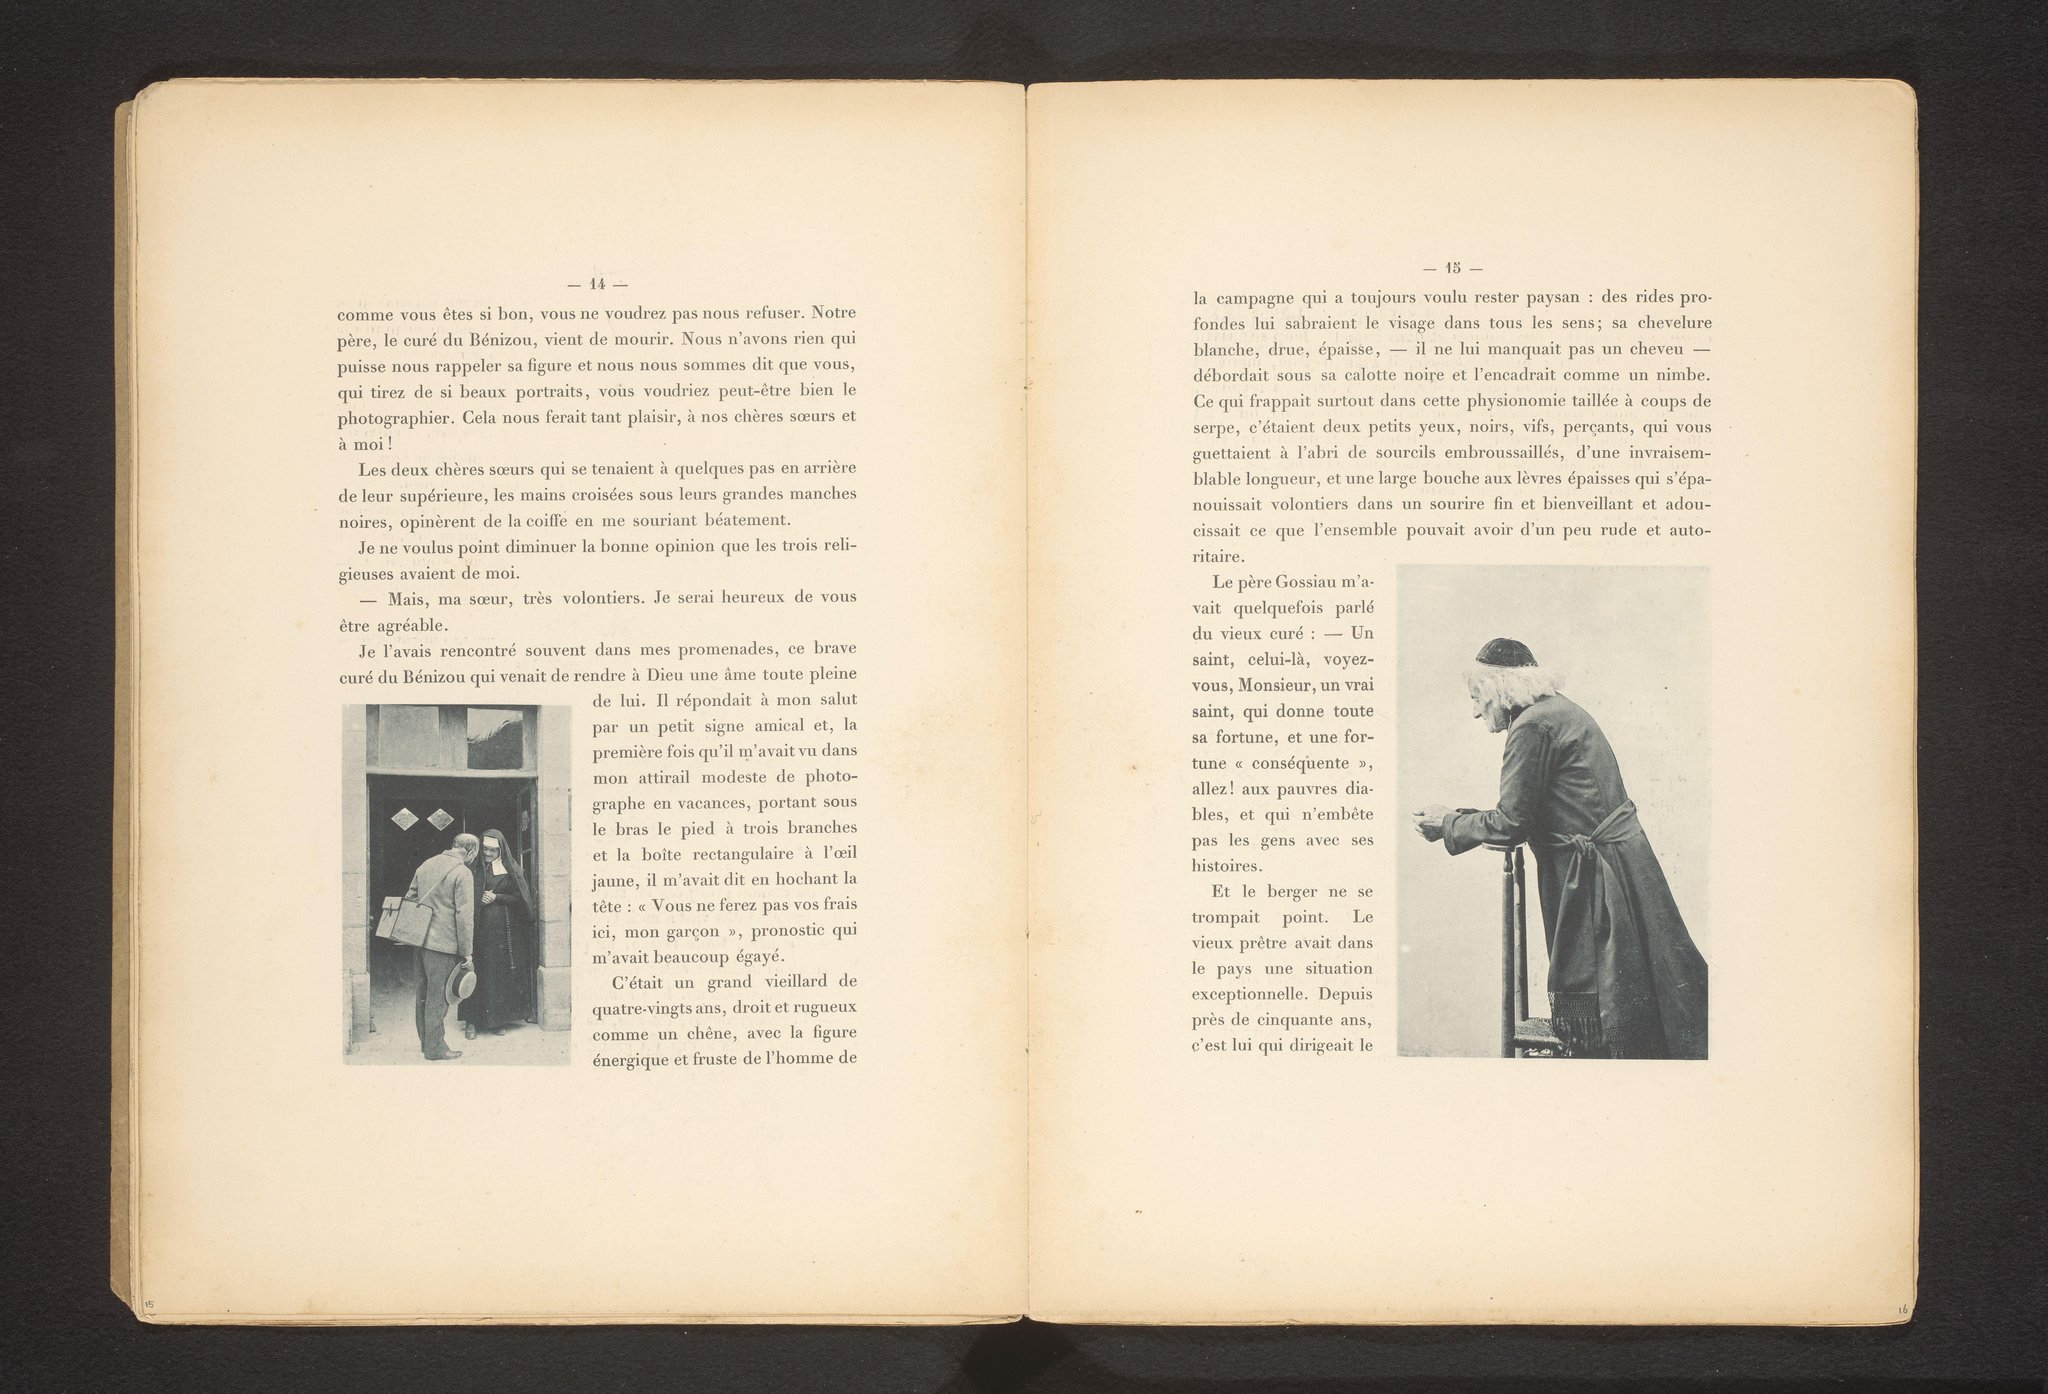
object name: page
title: Man met een tas en een hoed voor een non in een deuropening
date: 1885-1895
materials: paper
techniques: photograph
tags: nun(s)